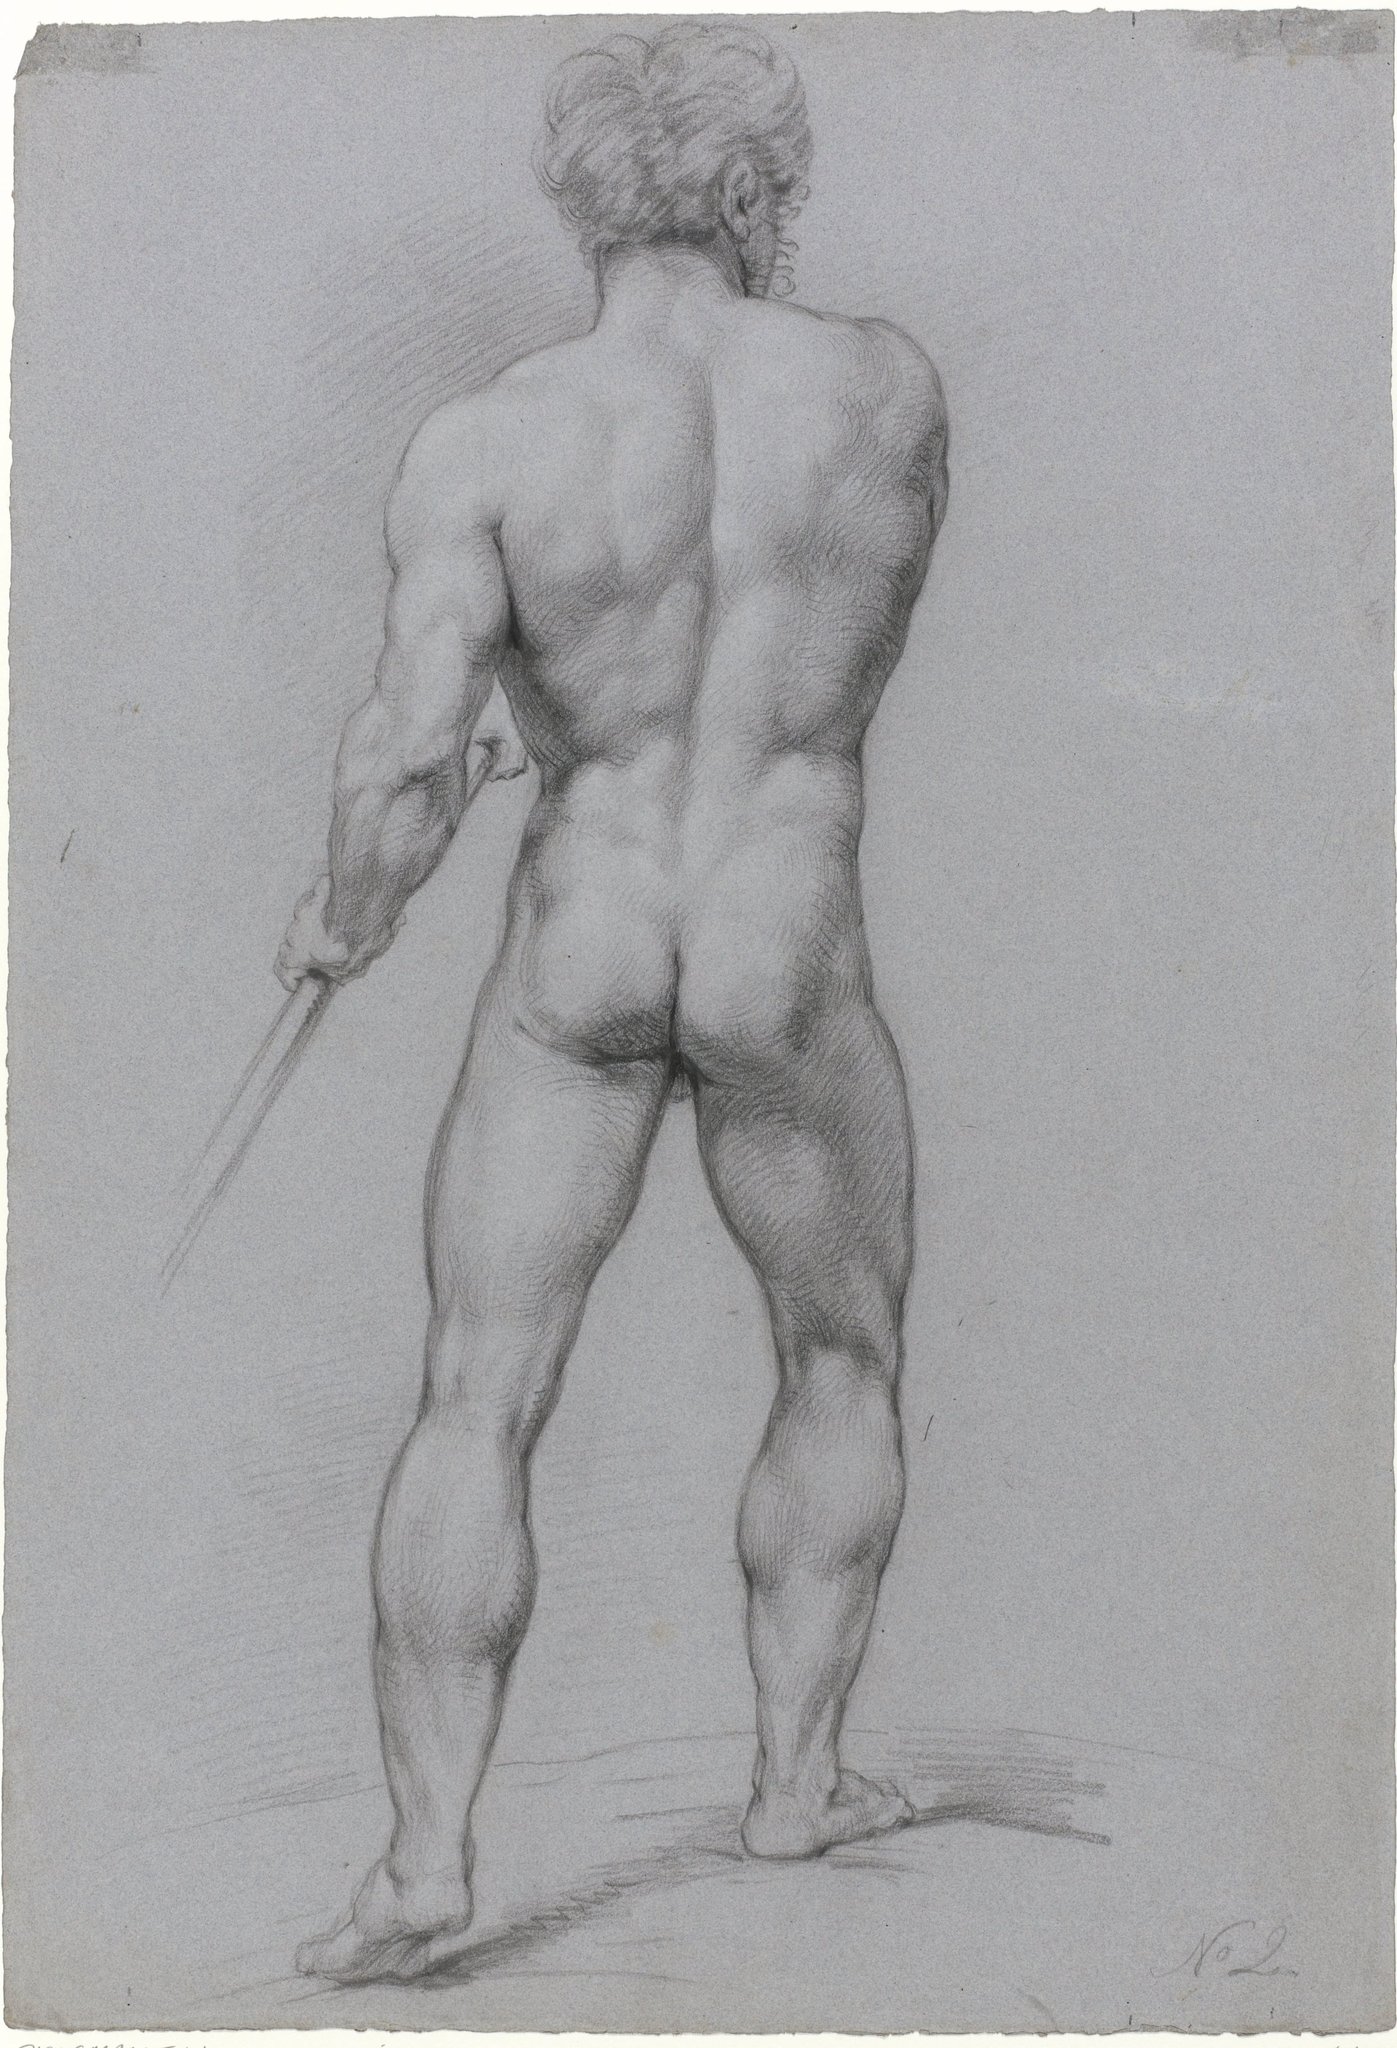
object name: drawing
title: Staand mannelijk naakt, op de rug gezien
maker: jan willem pieneman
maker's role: draughtsman, painter, print maker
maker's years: 1779-1853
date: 1789-1853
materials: chalk, paper